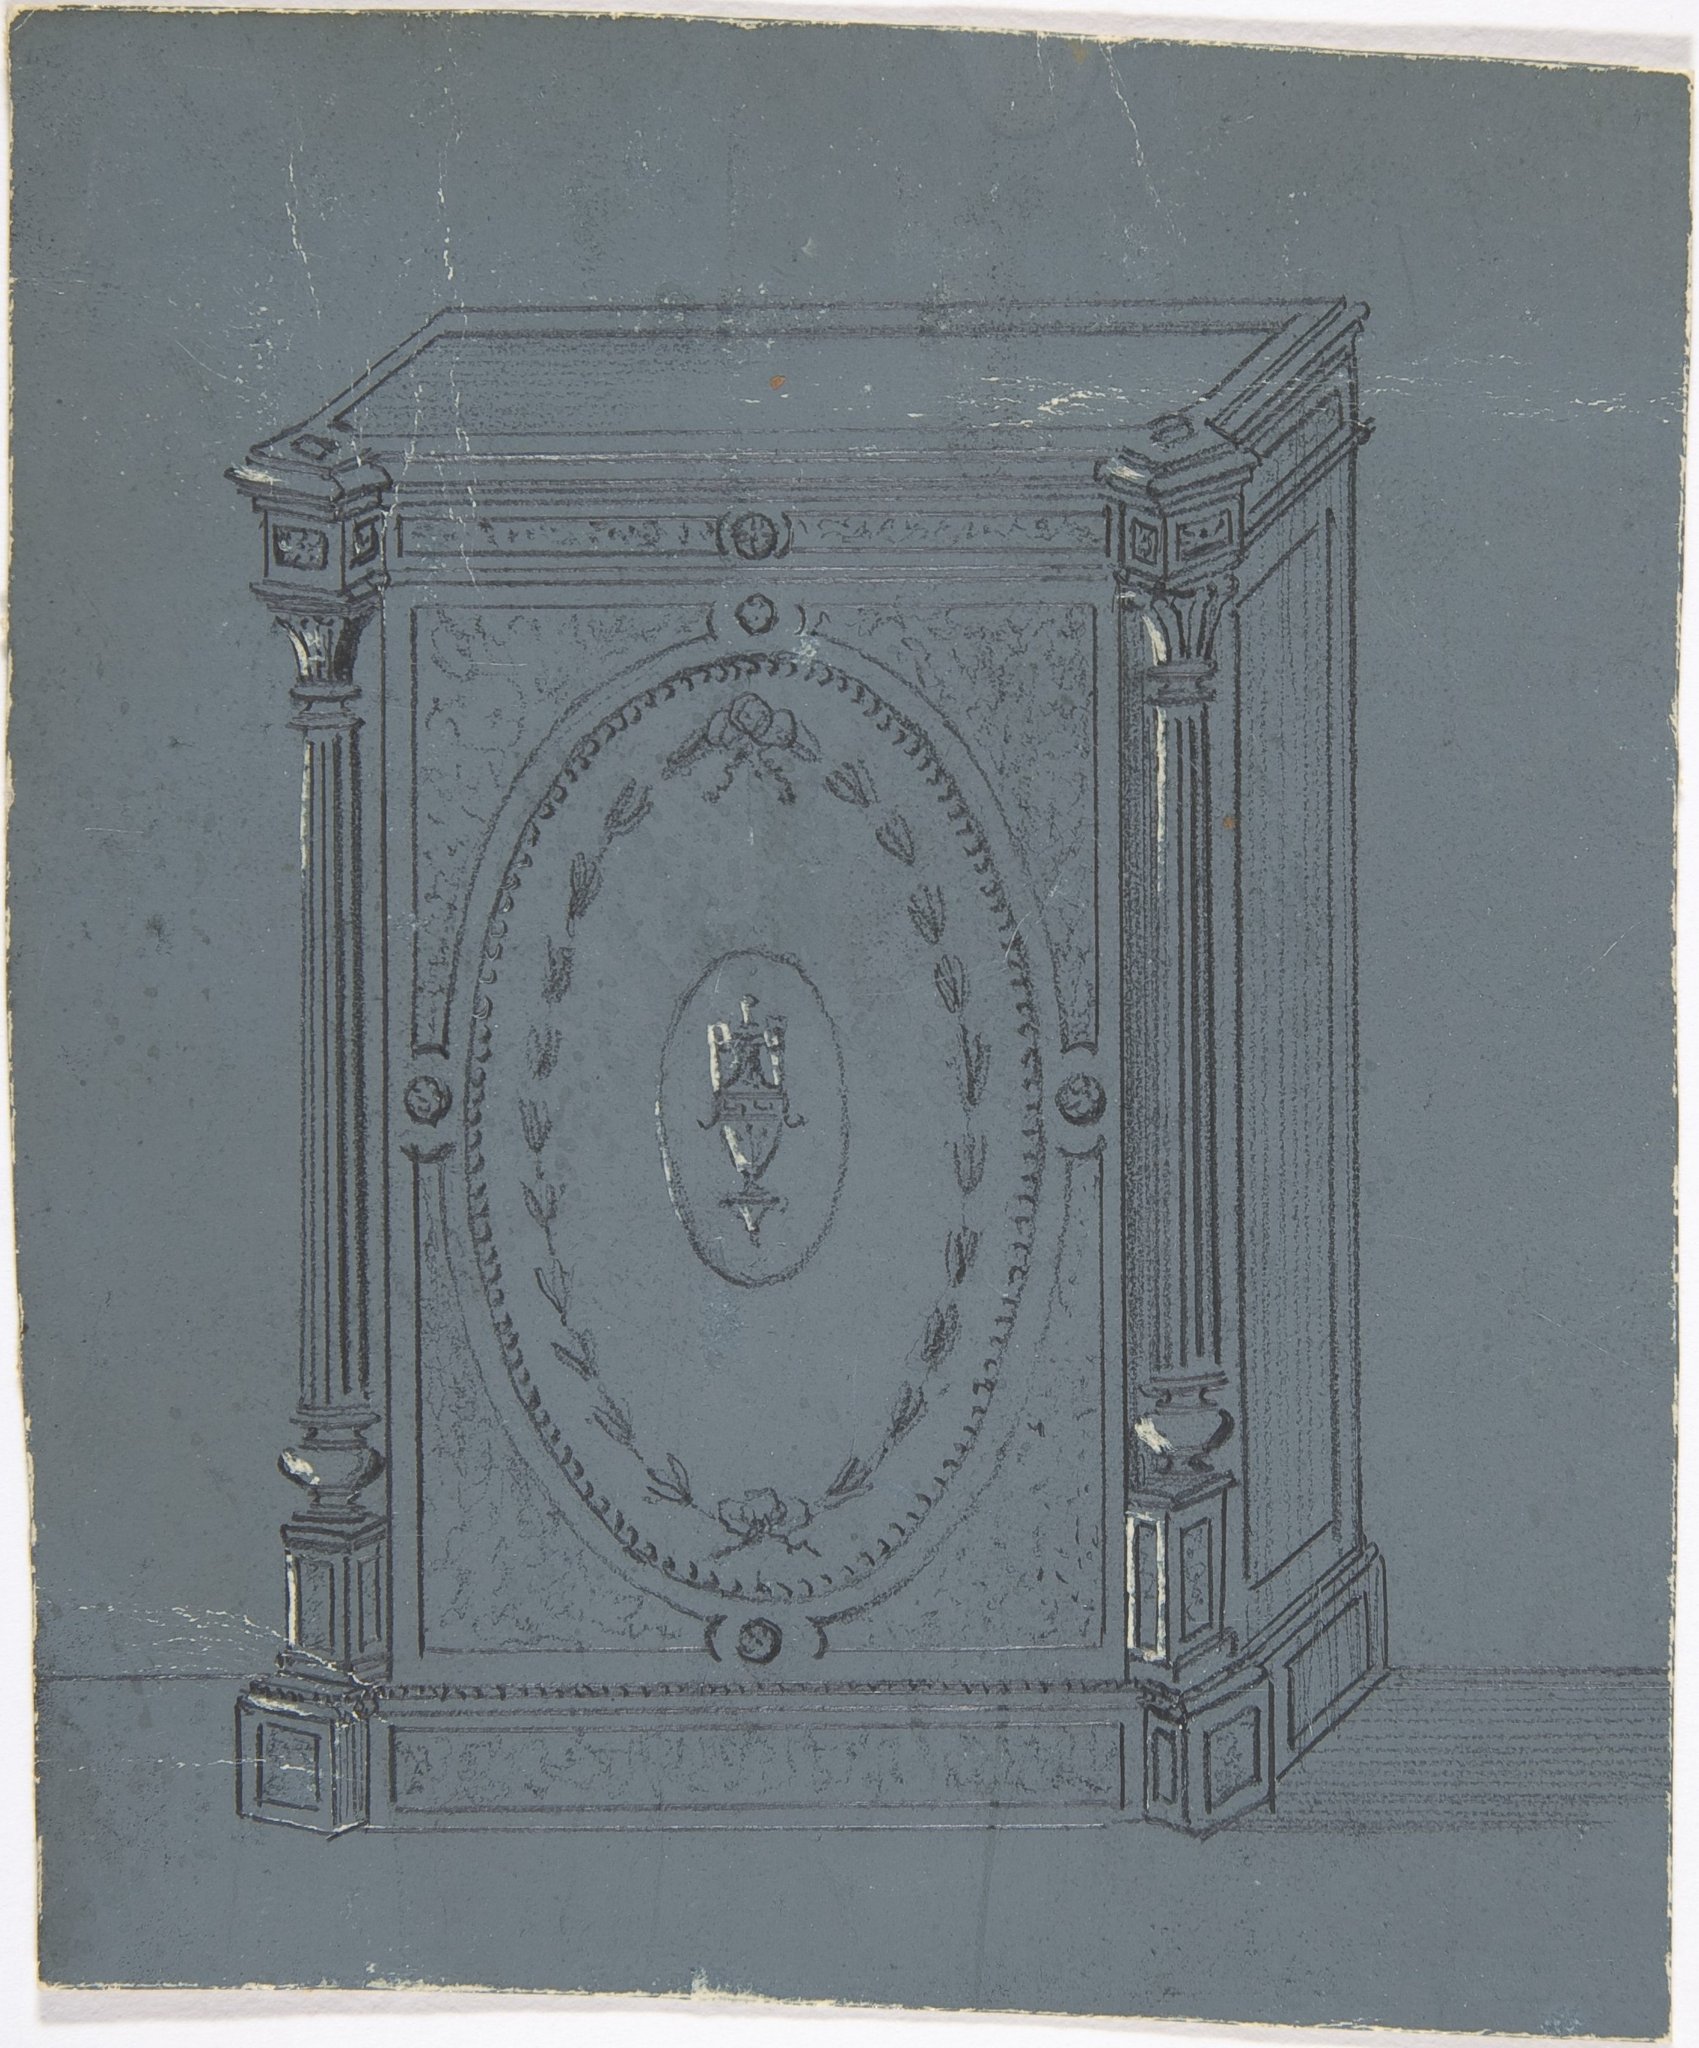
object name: drawing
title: Cabinet Design with a Central Urn Ornament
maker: anonymous, british, 19th century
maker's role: artist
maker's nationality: british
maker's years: 1800-1900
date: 1801-1900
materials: graphite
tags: cabinets